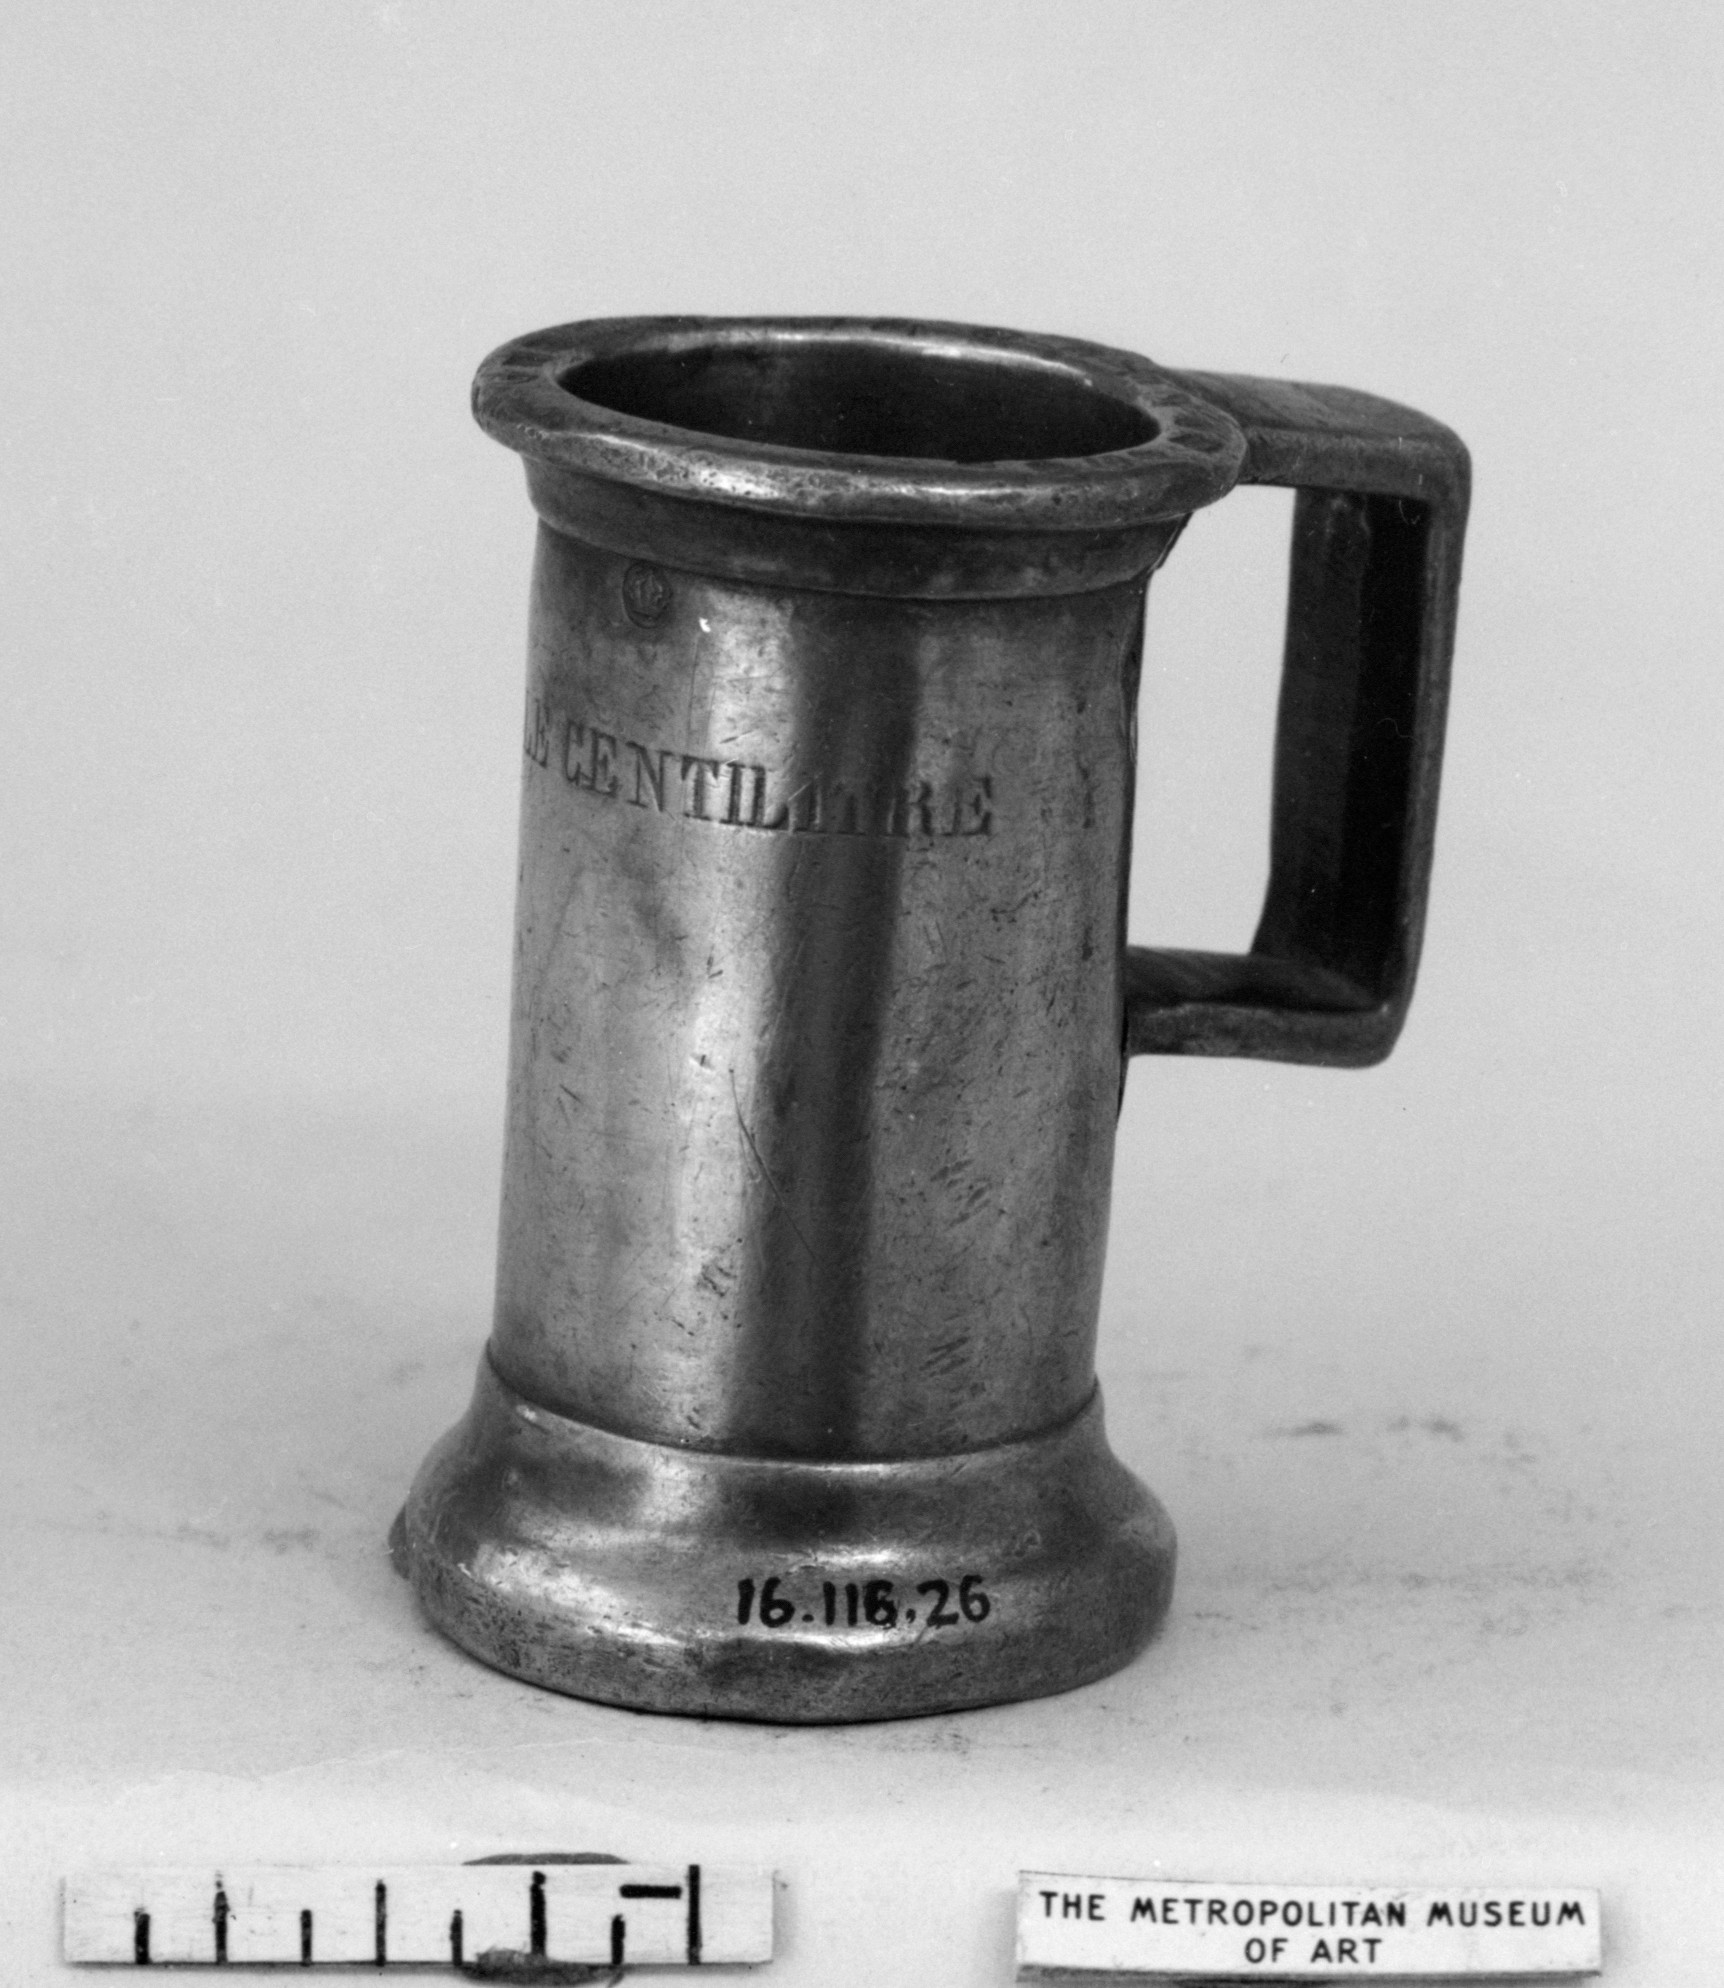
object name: measure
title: Measure (one of a set of seven)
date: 1801-1900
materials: pewter